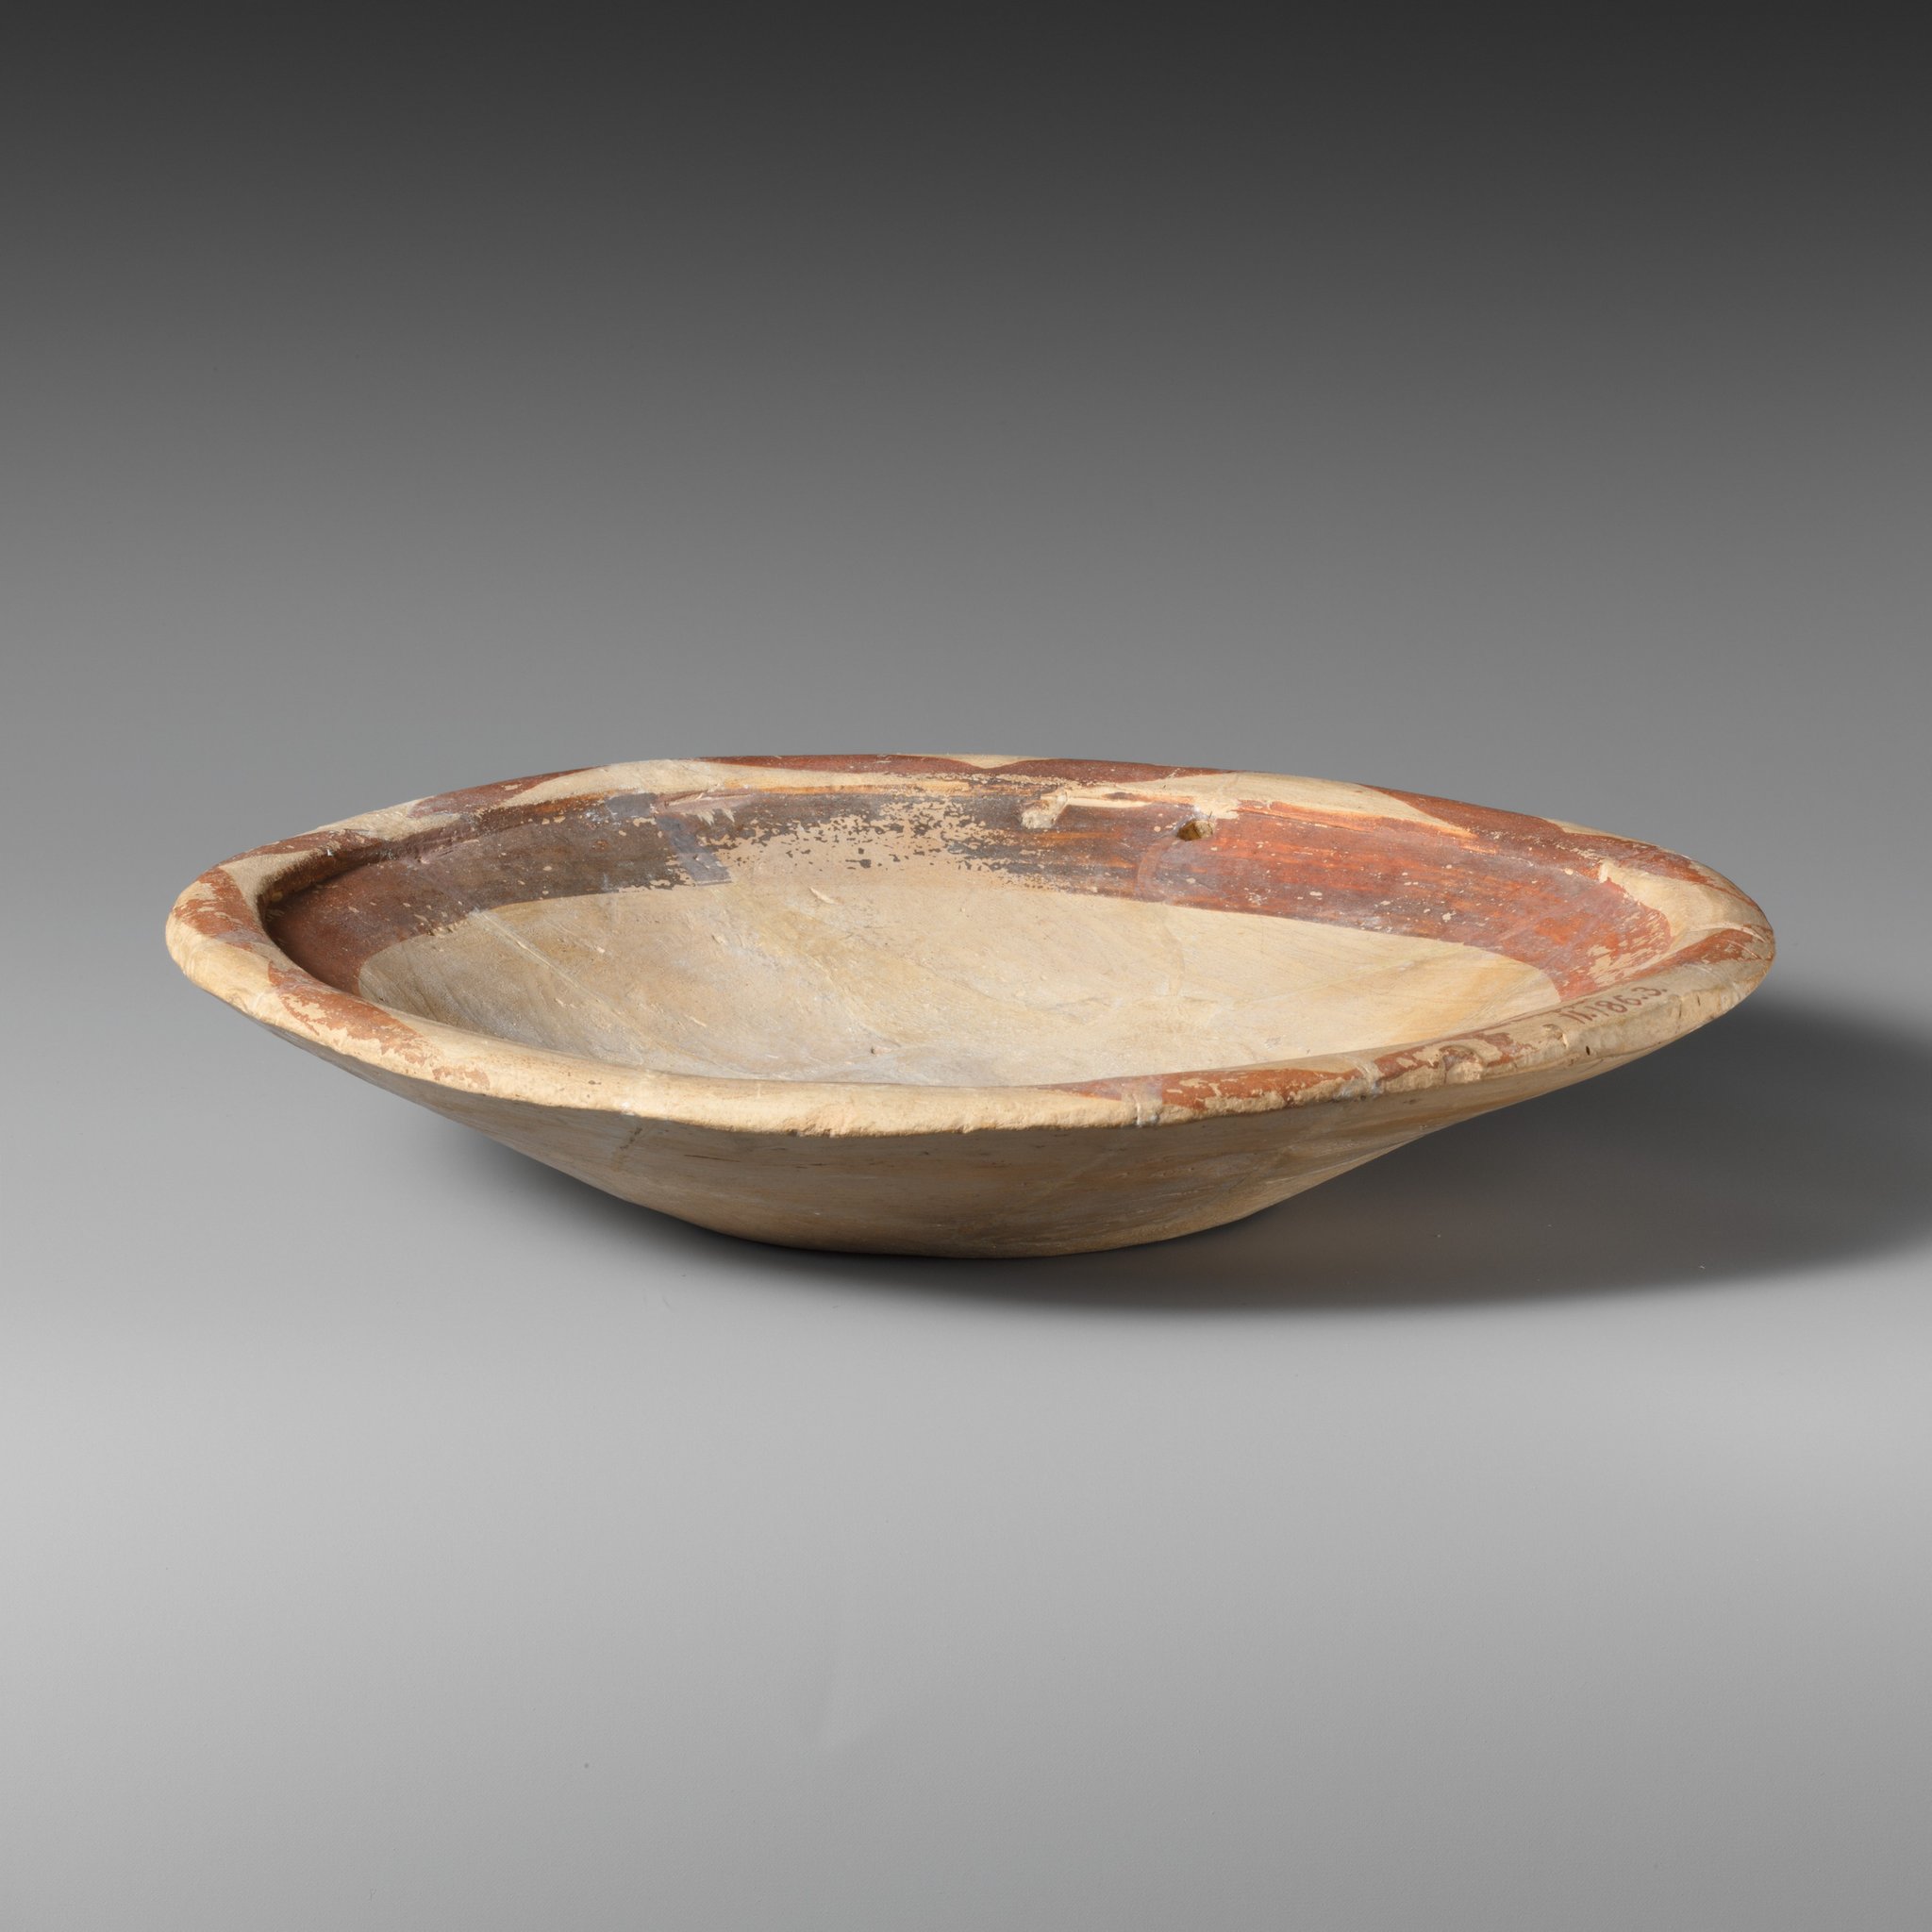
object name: plate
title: Terracotta shallow bowl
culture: minoan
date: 2900-2300 BCE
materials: terracotta